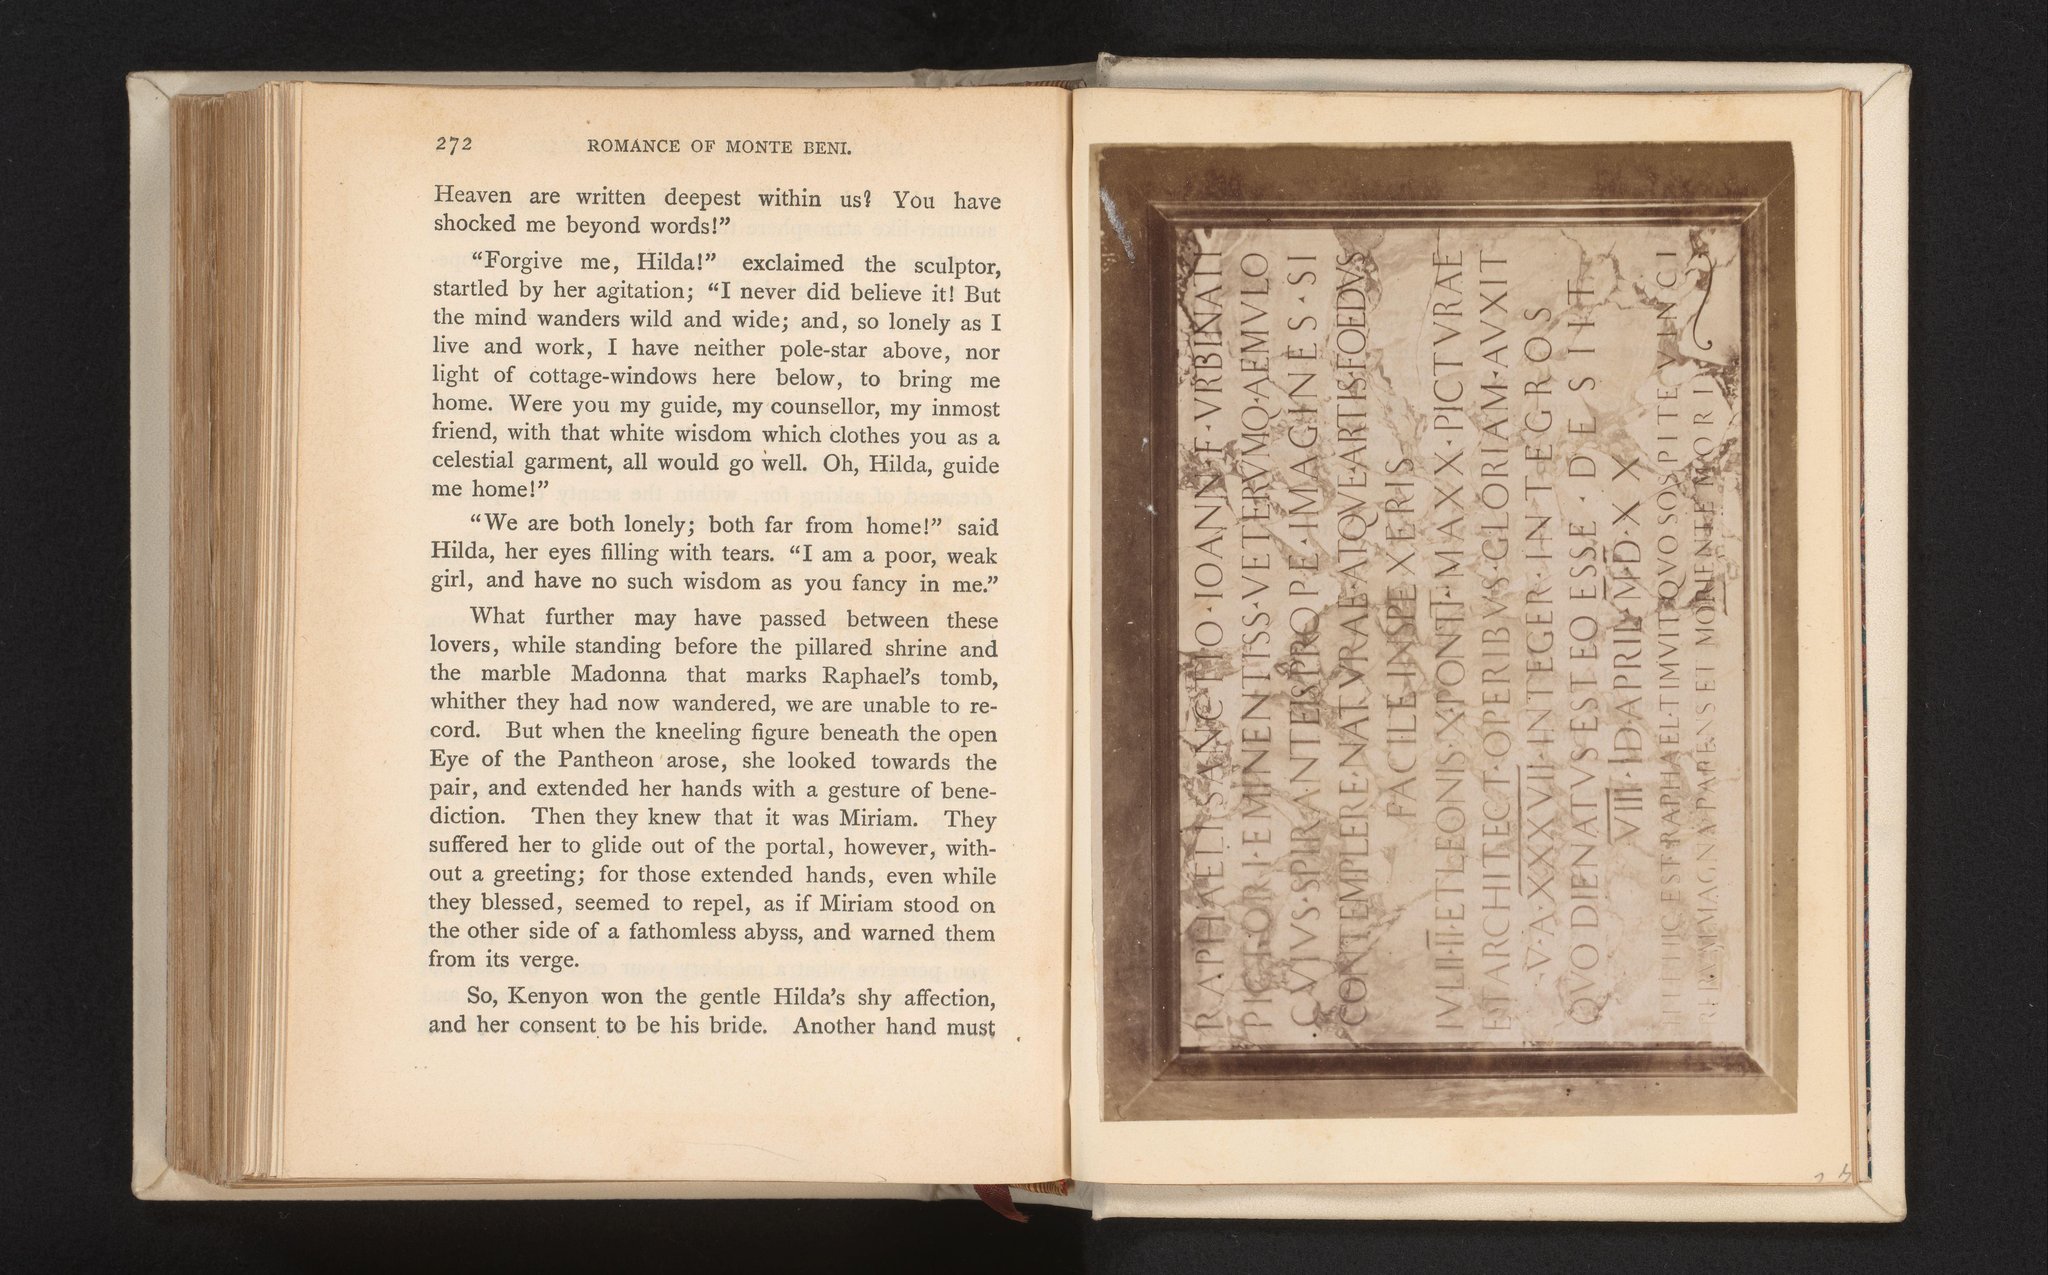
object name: photograph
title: Inscriptie op de tombe van Rafaël in het Pantheon in Rome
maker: Anonymous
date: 1850-1860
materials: photographic support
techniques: albumen print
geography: pantheon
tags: grave, tomb